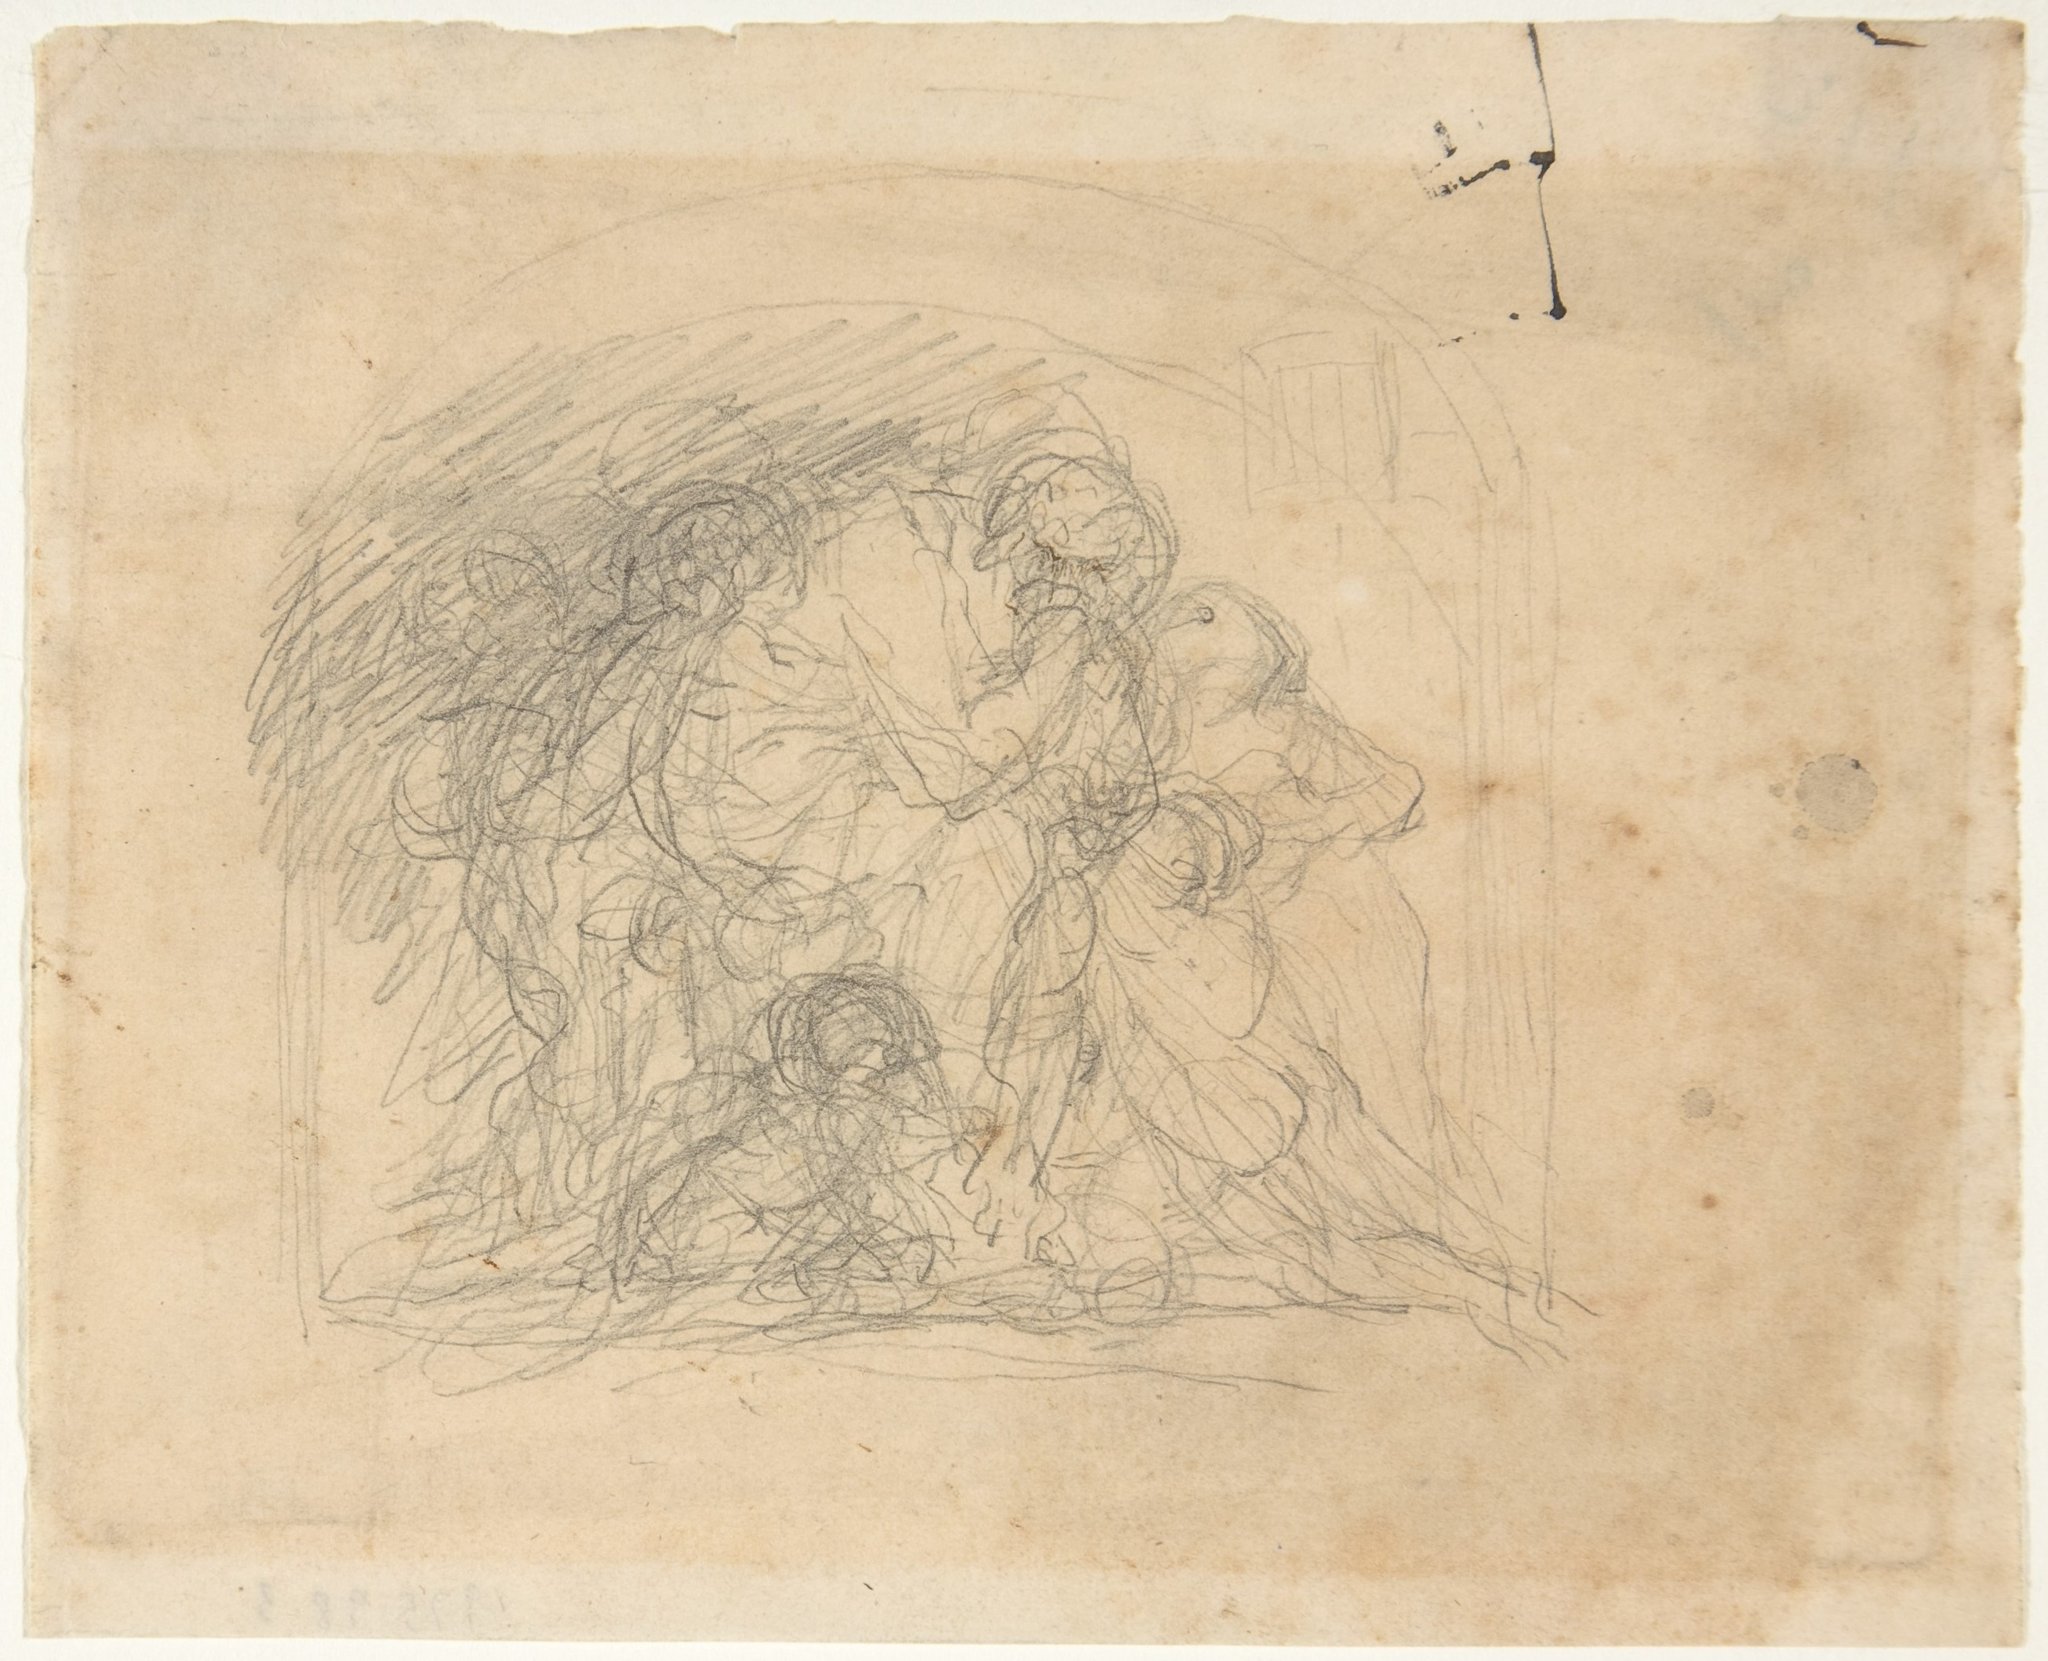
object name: drawing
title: Study for the Ugolino Group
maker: jean-baptiste carpeaux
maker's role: artist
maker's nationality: french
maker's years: 1827-1875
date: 1801-1900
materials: graphite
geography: france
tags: abstraction